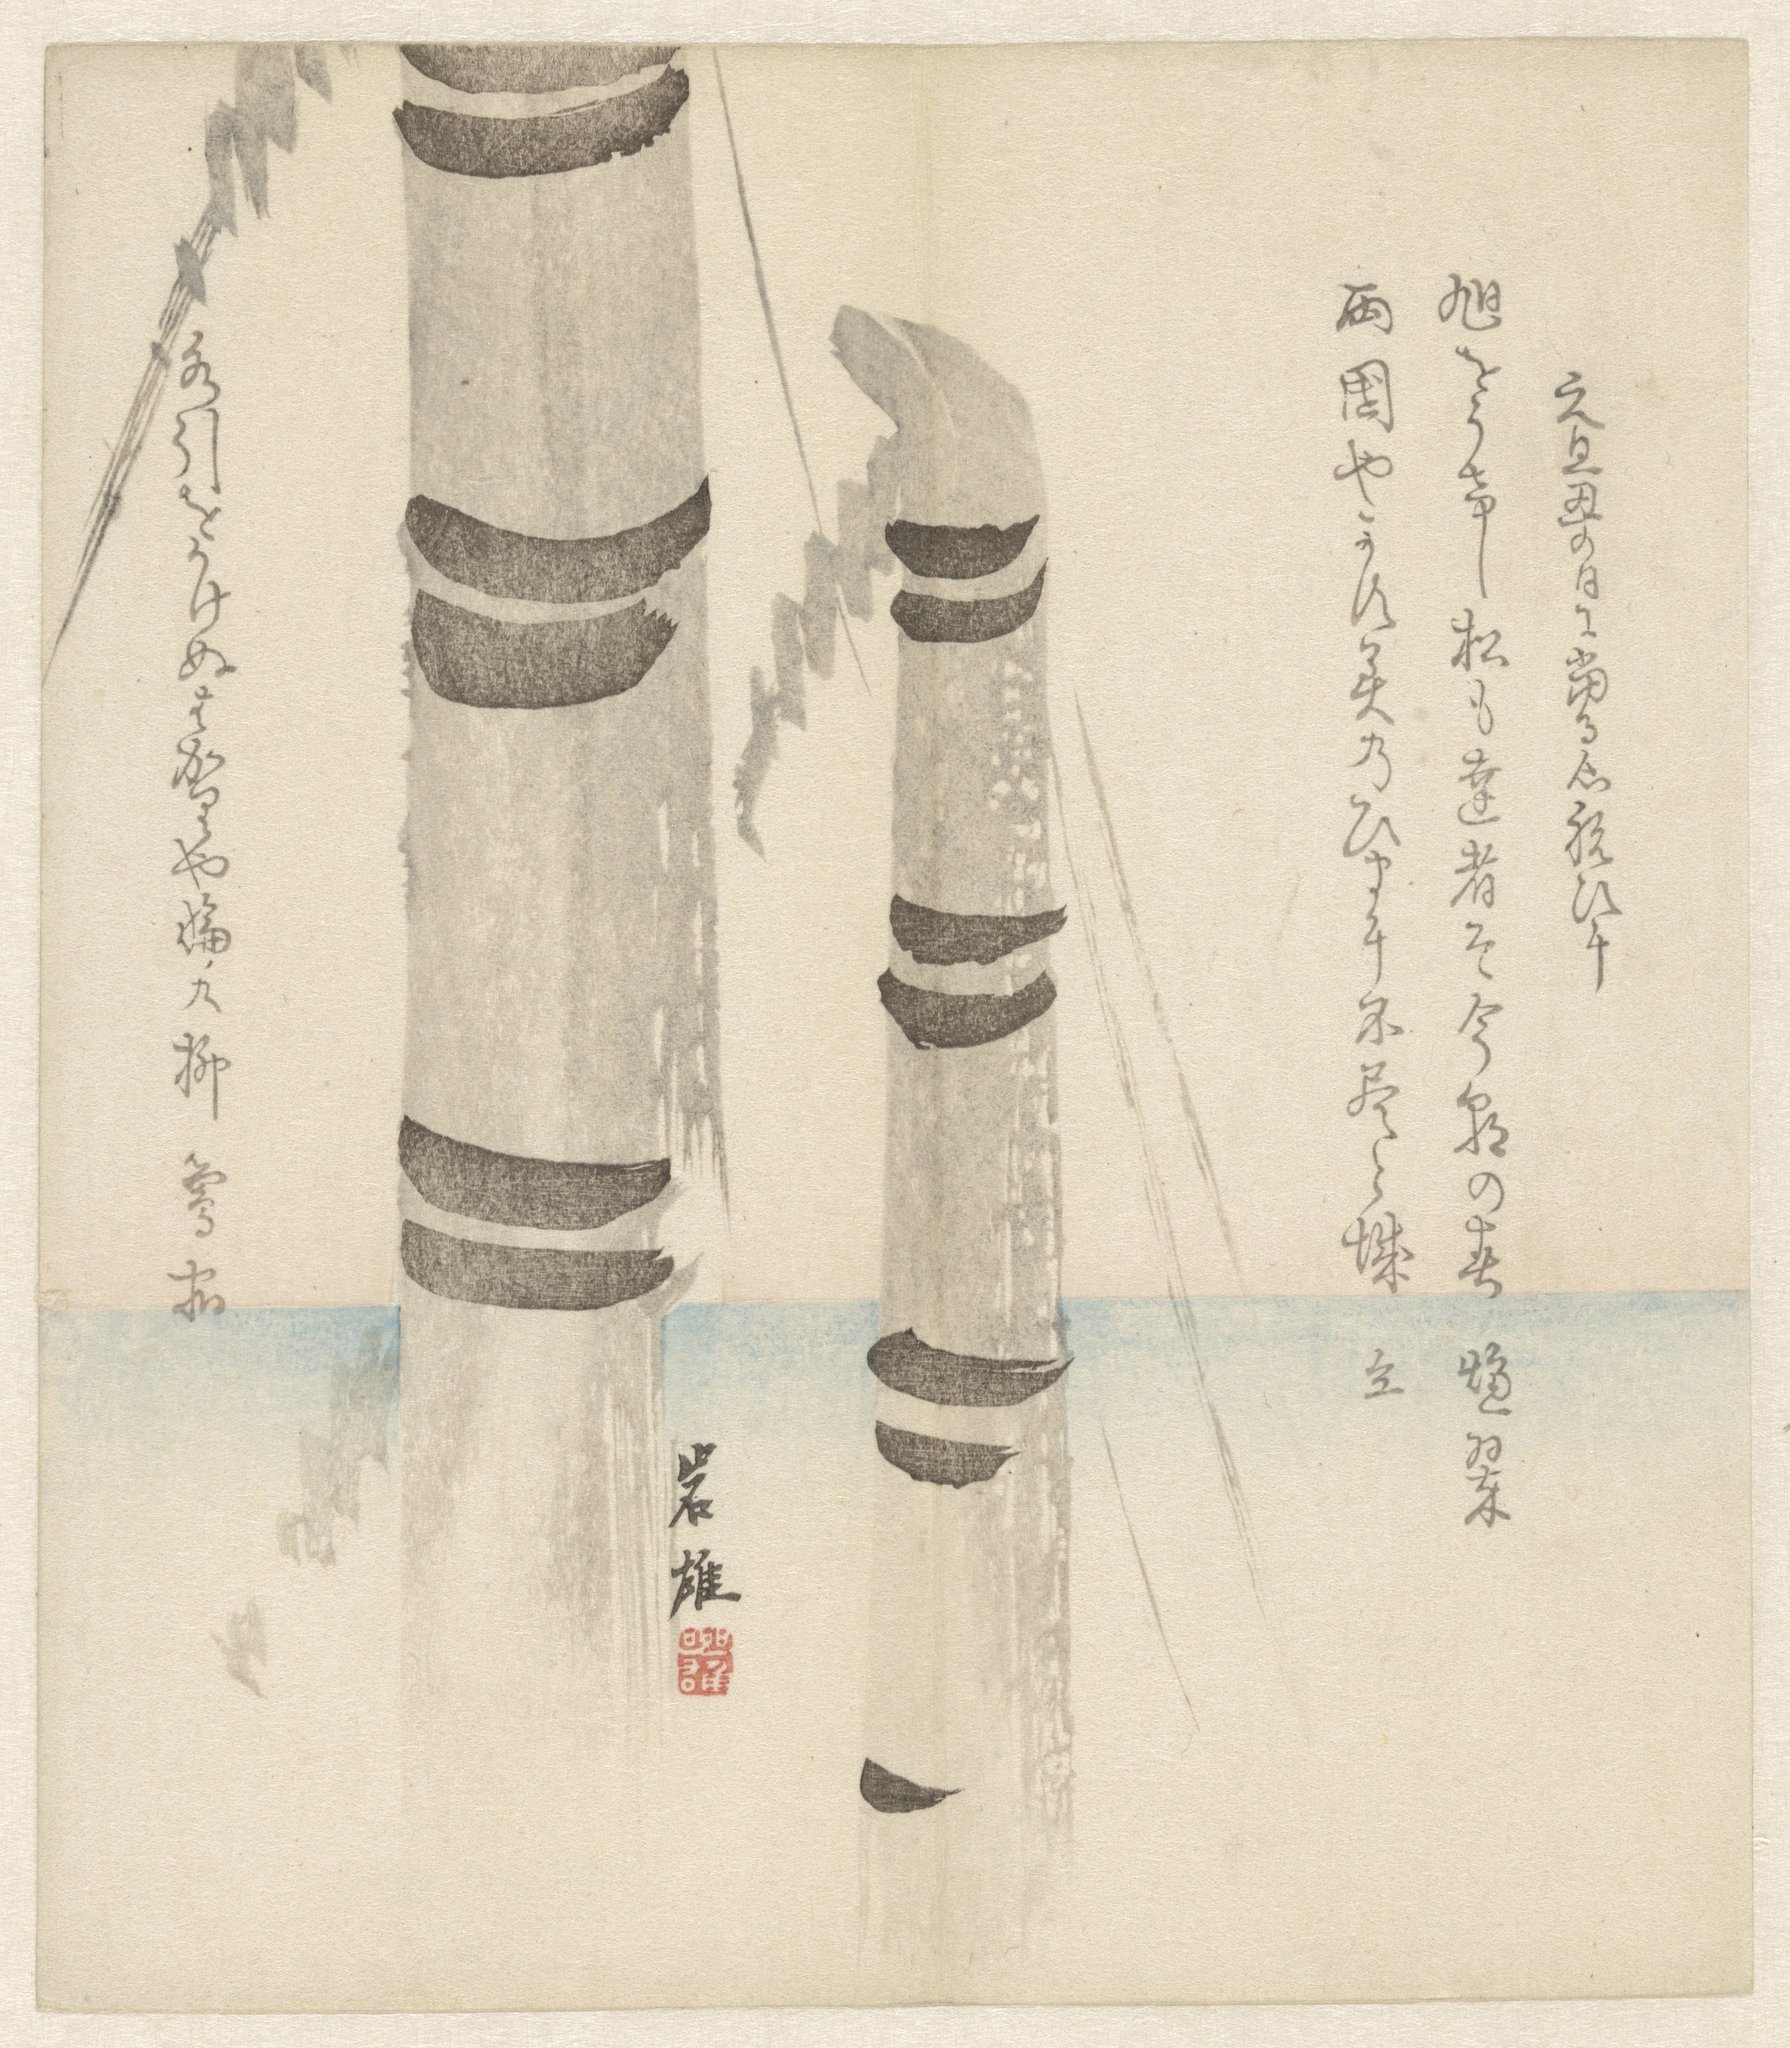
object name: surimono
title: Twee bamboestammen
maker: Anonymous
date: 1800-1900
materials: paper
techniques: woodcut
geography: japan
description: Een surimono is een luxe uitgevoerde prent waarop beeld met één of meerdere gedichten gecombineerd is. Bij het drukken van een surimono werd vaak gebruik gemaakt van dikker papier, blinddruk en metaal pigmenten, zoals koper- en zilverpoeder. De prenten werden vaak in opdracht van dichters gemaakt en als exclusief geschenk aan vrienden en relaties gegeven.